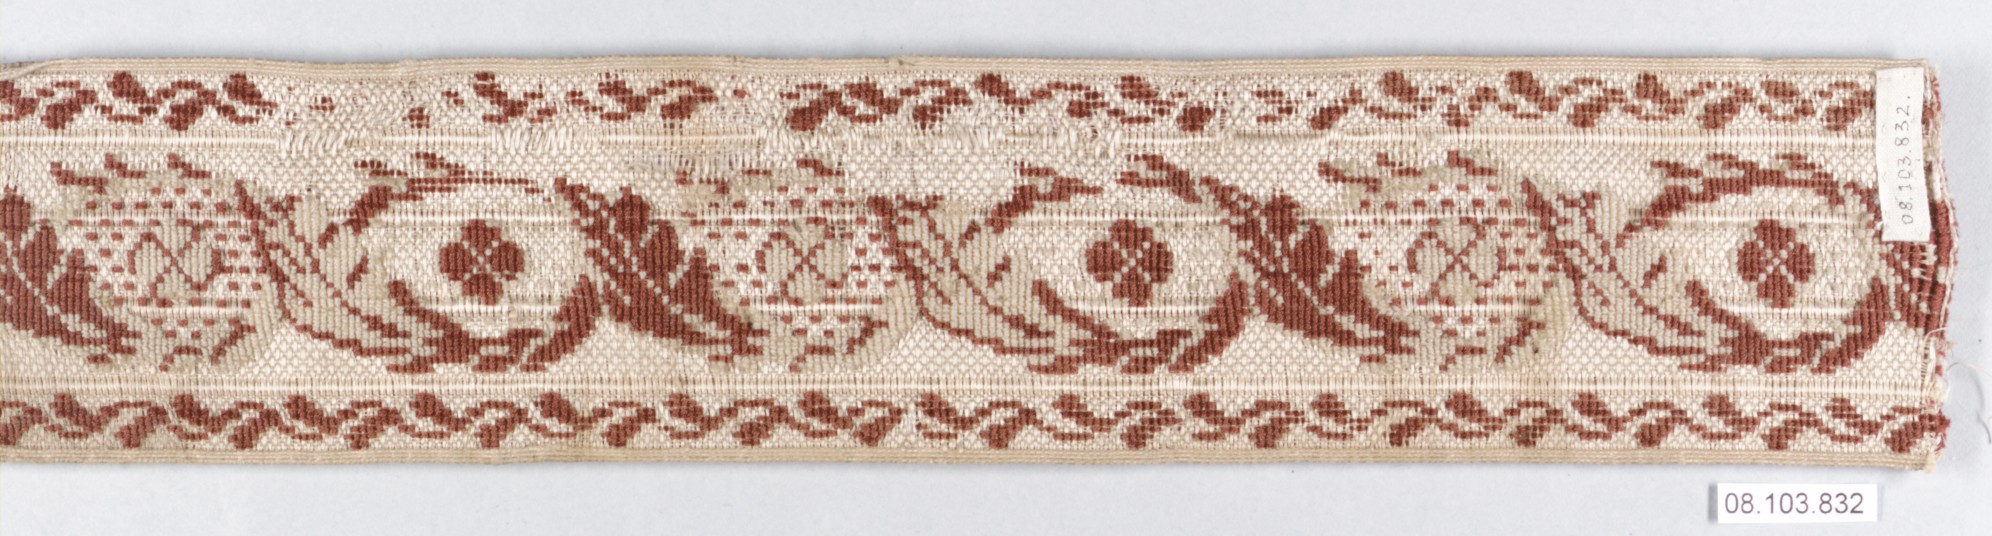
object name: galloon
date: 1701-1900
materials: silk, wool